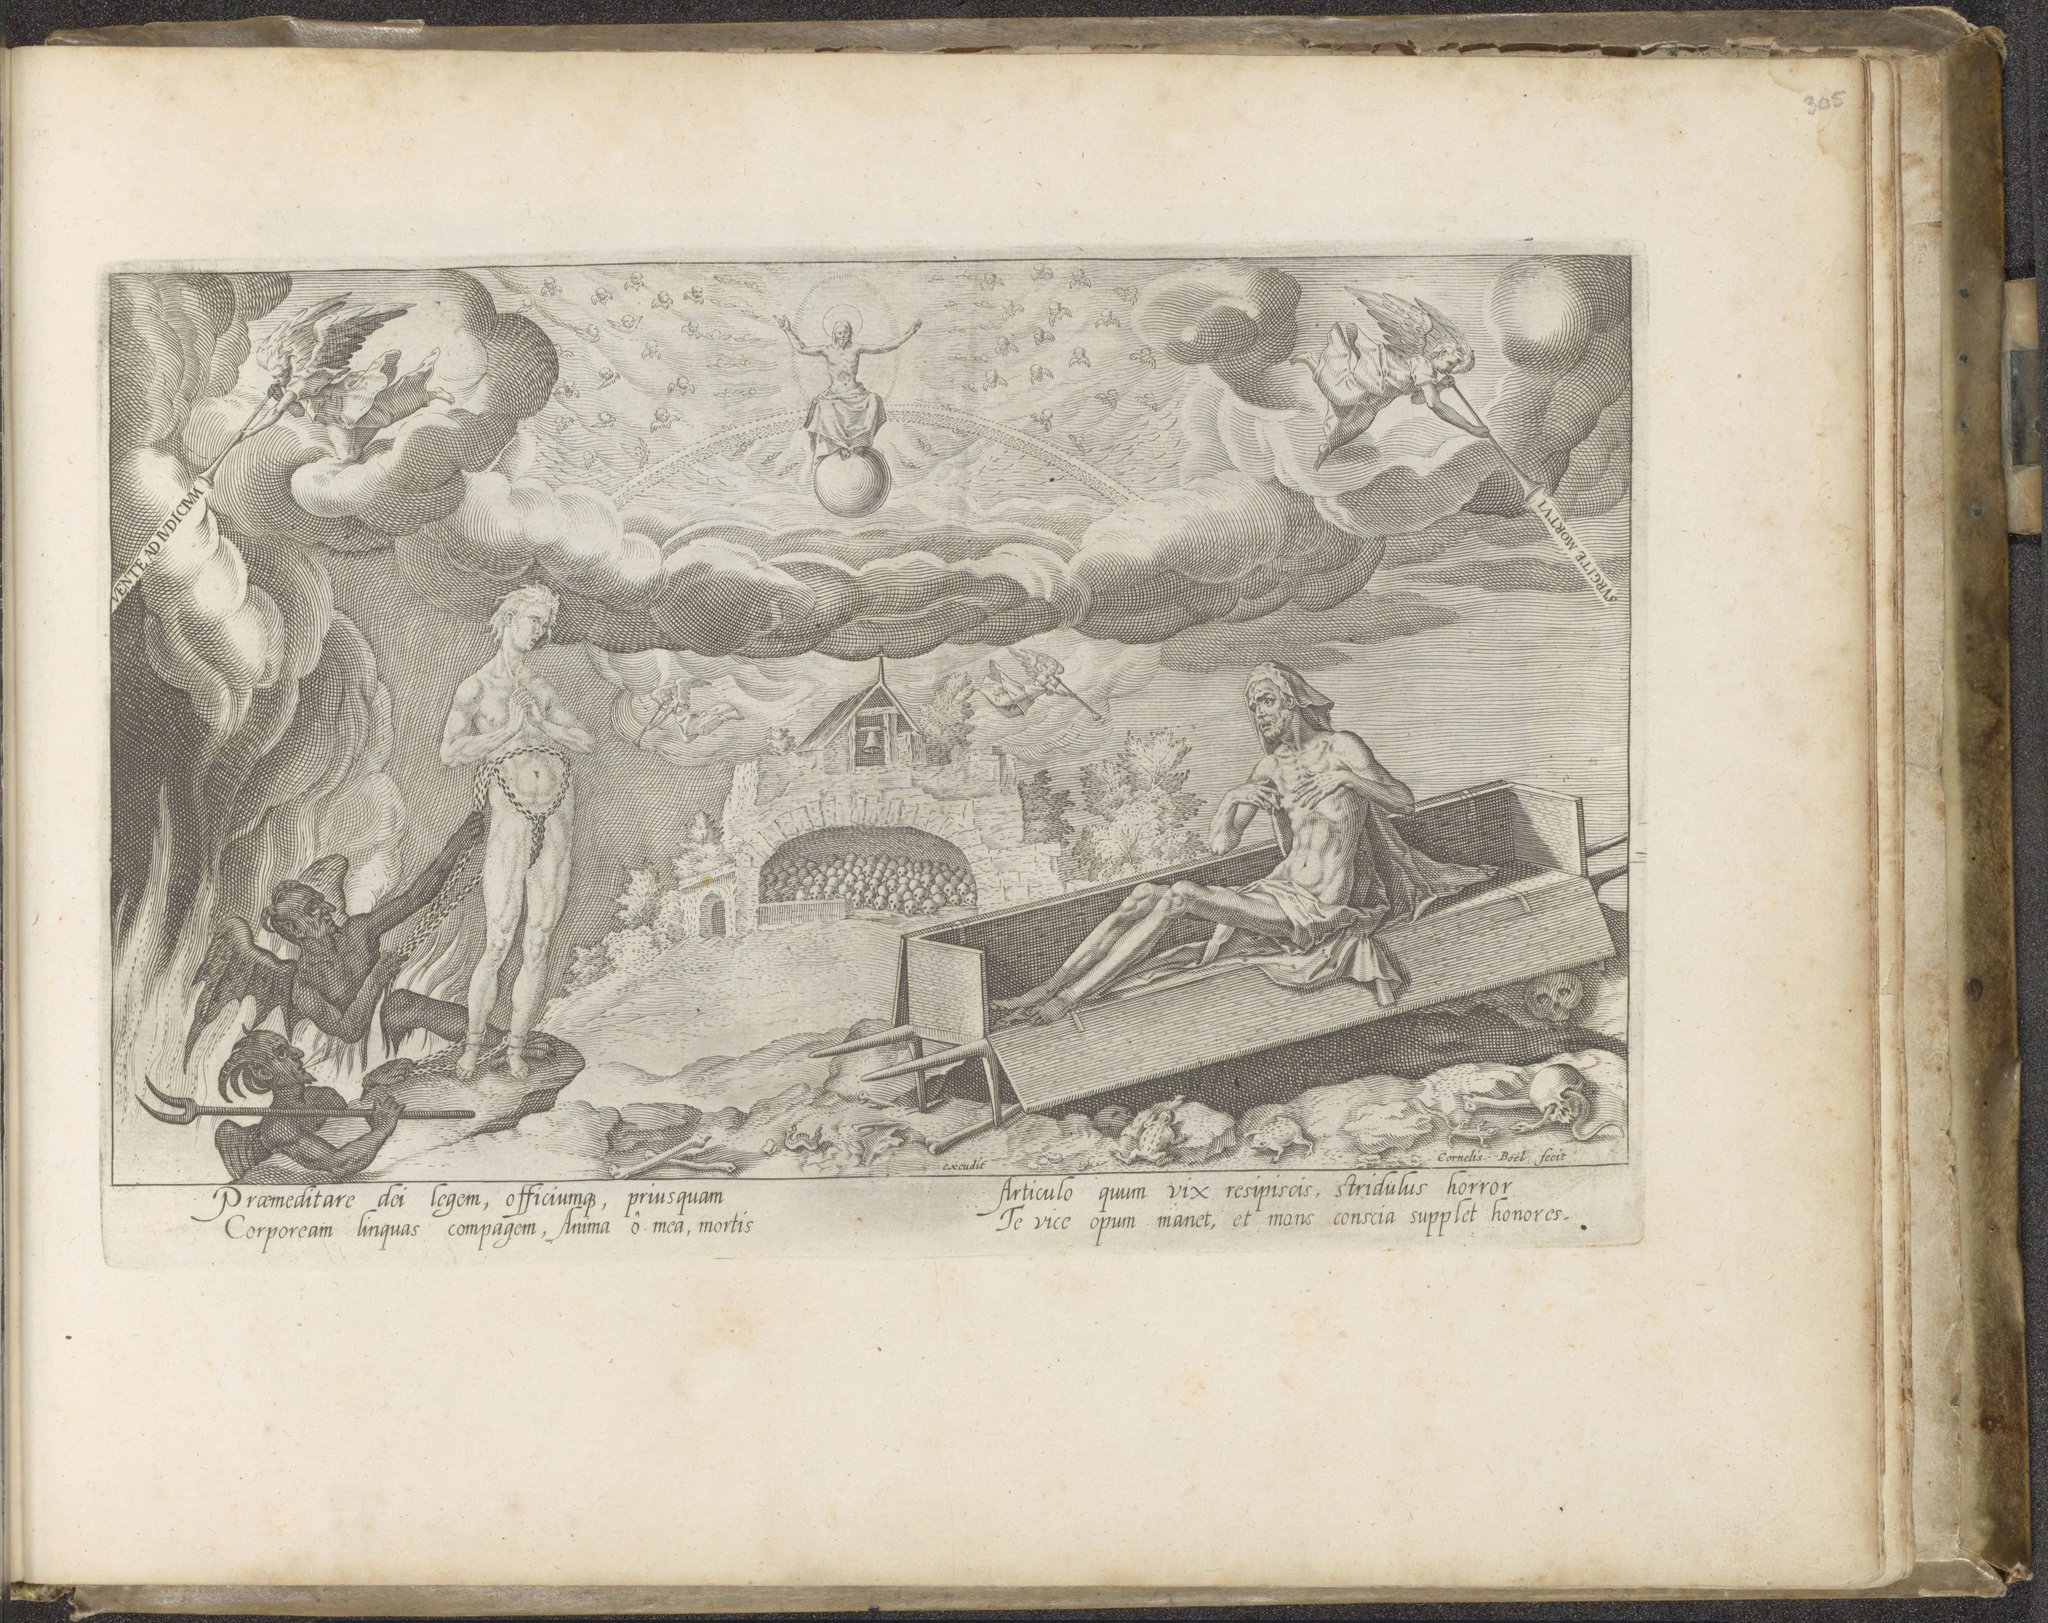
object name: print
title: Den Grooten Emblemata Sacra, bestaande in meer dan vier hondert bybelsche figuren, zoo des Ouden als des Nieuwen Testaments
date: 1590-1621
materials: paper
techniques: engraving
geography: amsterdam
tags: last judgement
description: Christus zit als rechter op de regenboog, zijn voeten rusten op de wereldbol. Hij maakt een spreekgebaar en wordt omringd door cherubijnen. Aan weerszijden van hem twee trompetterende engelen. Onder staat een dode op uit zijn graf, een ander wordt door twee duivels de hel ingetrokken. Met een Latijns onderschrift. De prent maakt deel uit van een album.